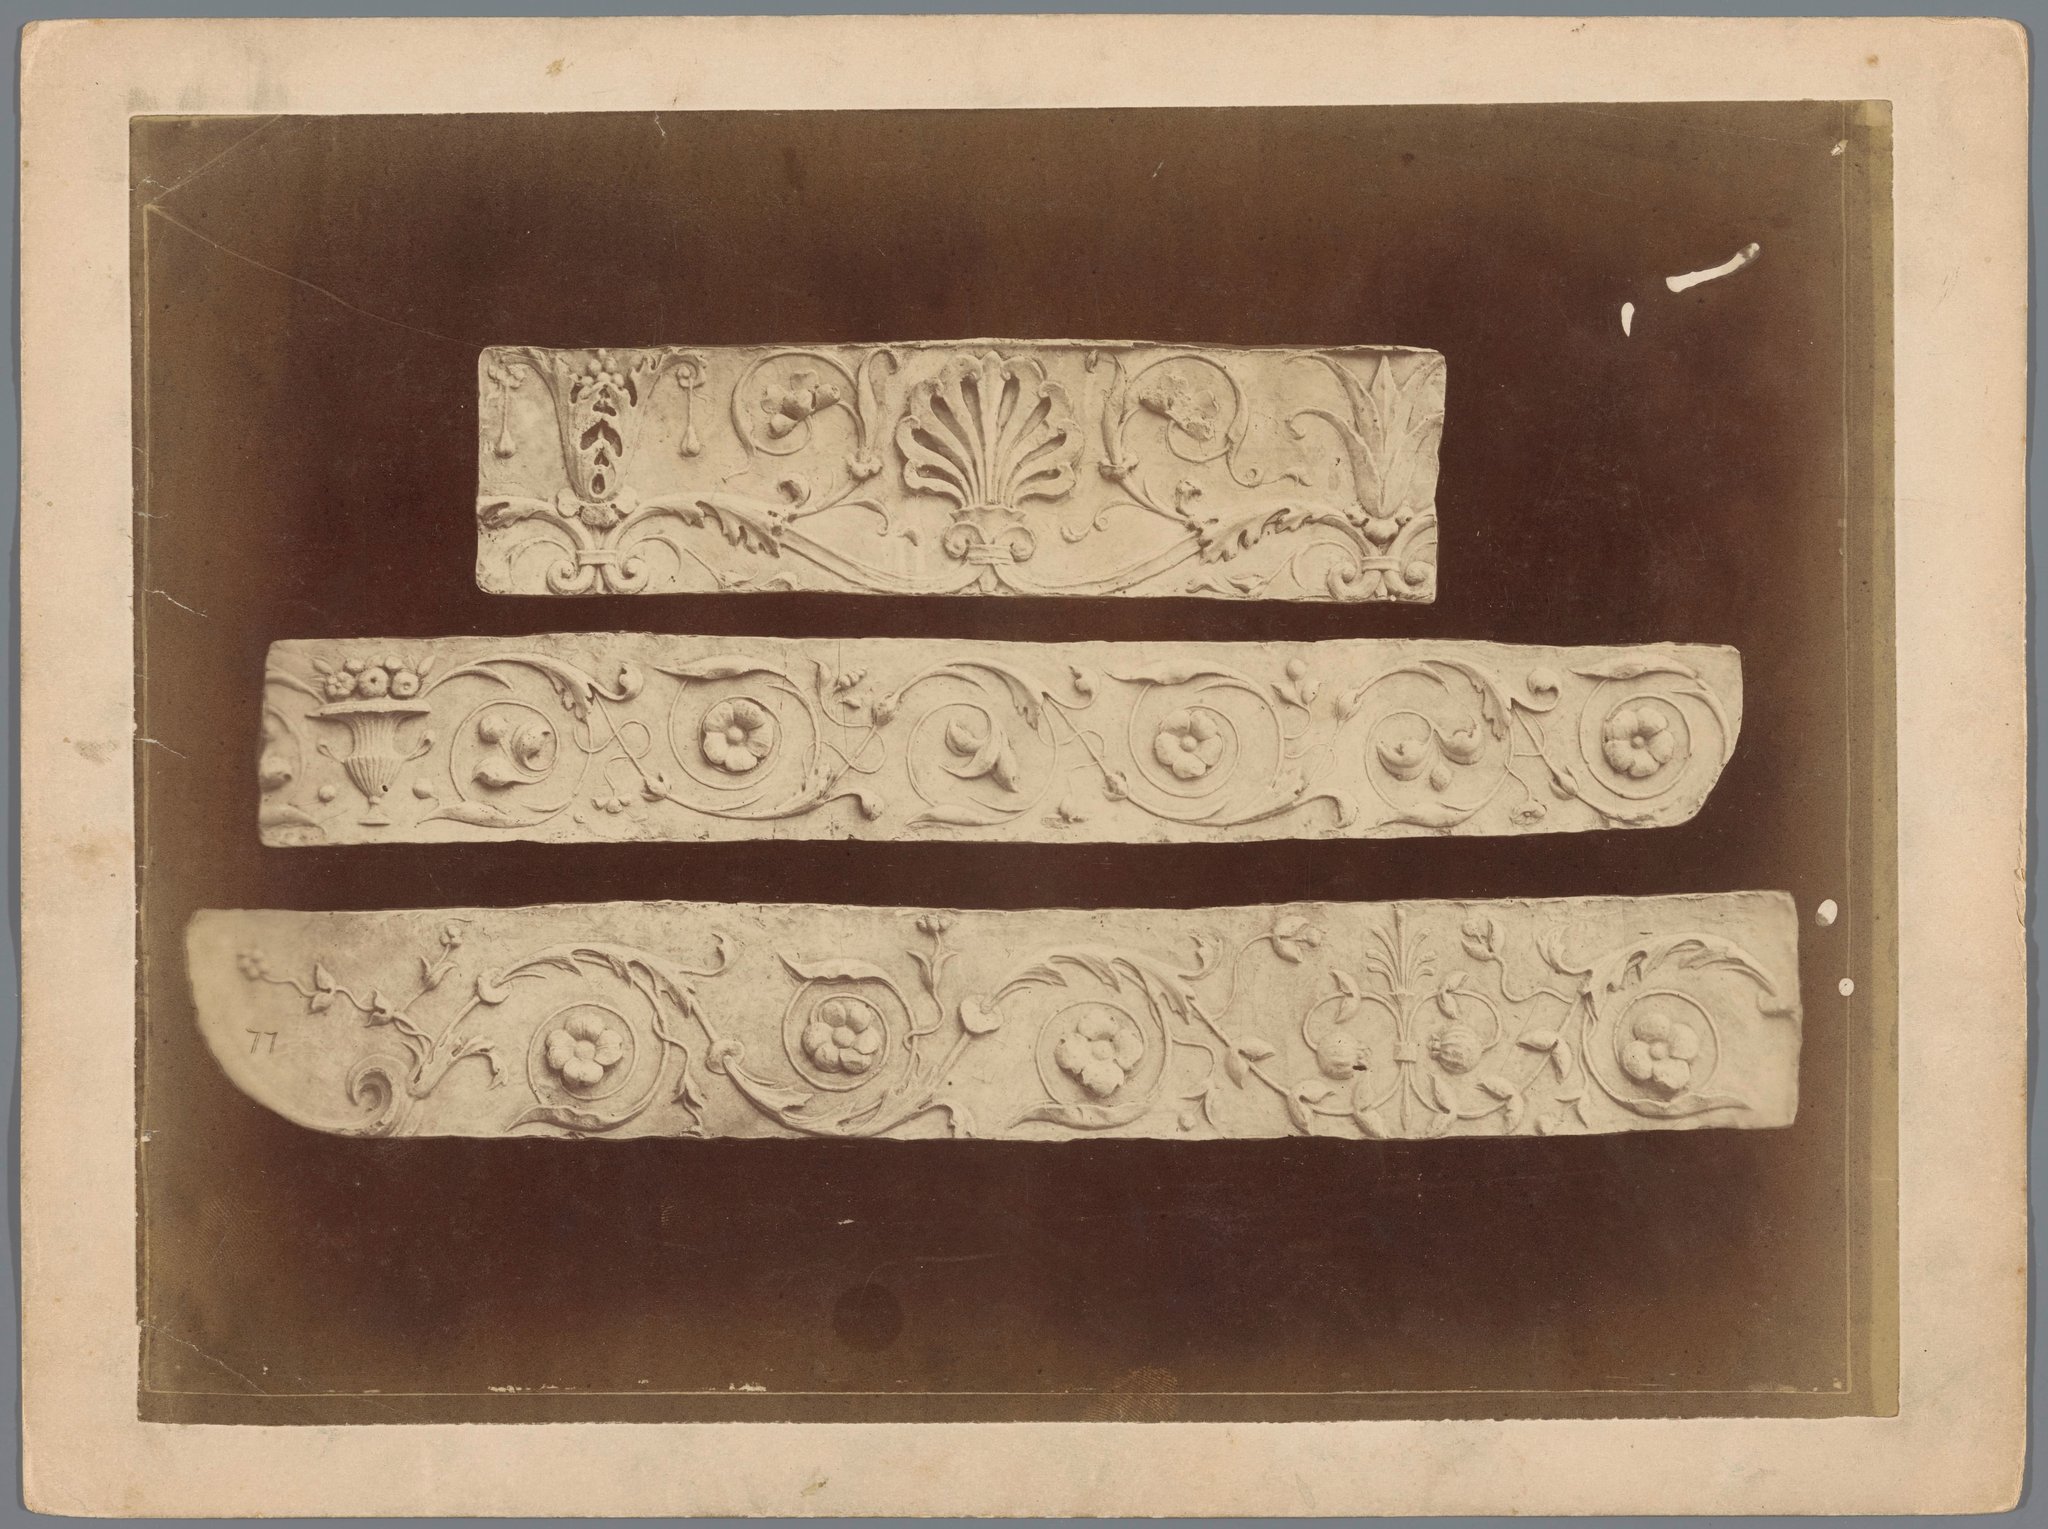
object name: photograph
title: Drie reliëfs met bloemmotieven en een schelp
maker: Anonymous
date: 1875-1900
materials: cardboard, photographic support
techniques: albumen print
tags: floral interlace ~ ornament, scallop, shell ~ ornament, sculpture (+ relief ~ sculpture)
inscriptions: collector's mark: Lugt 3937